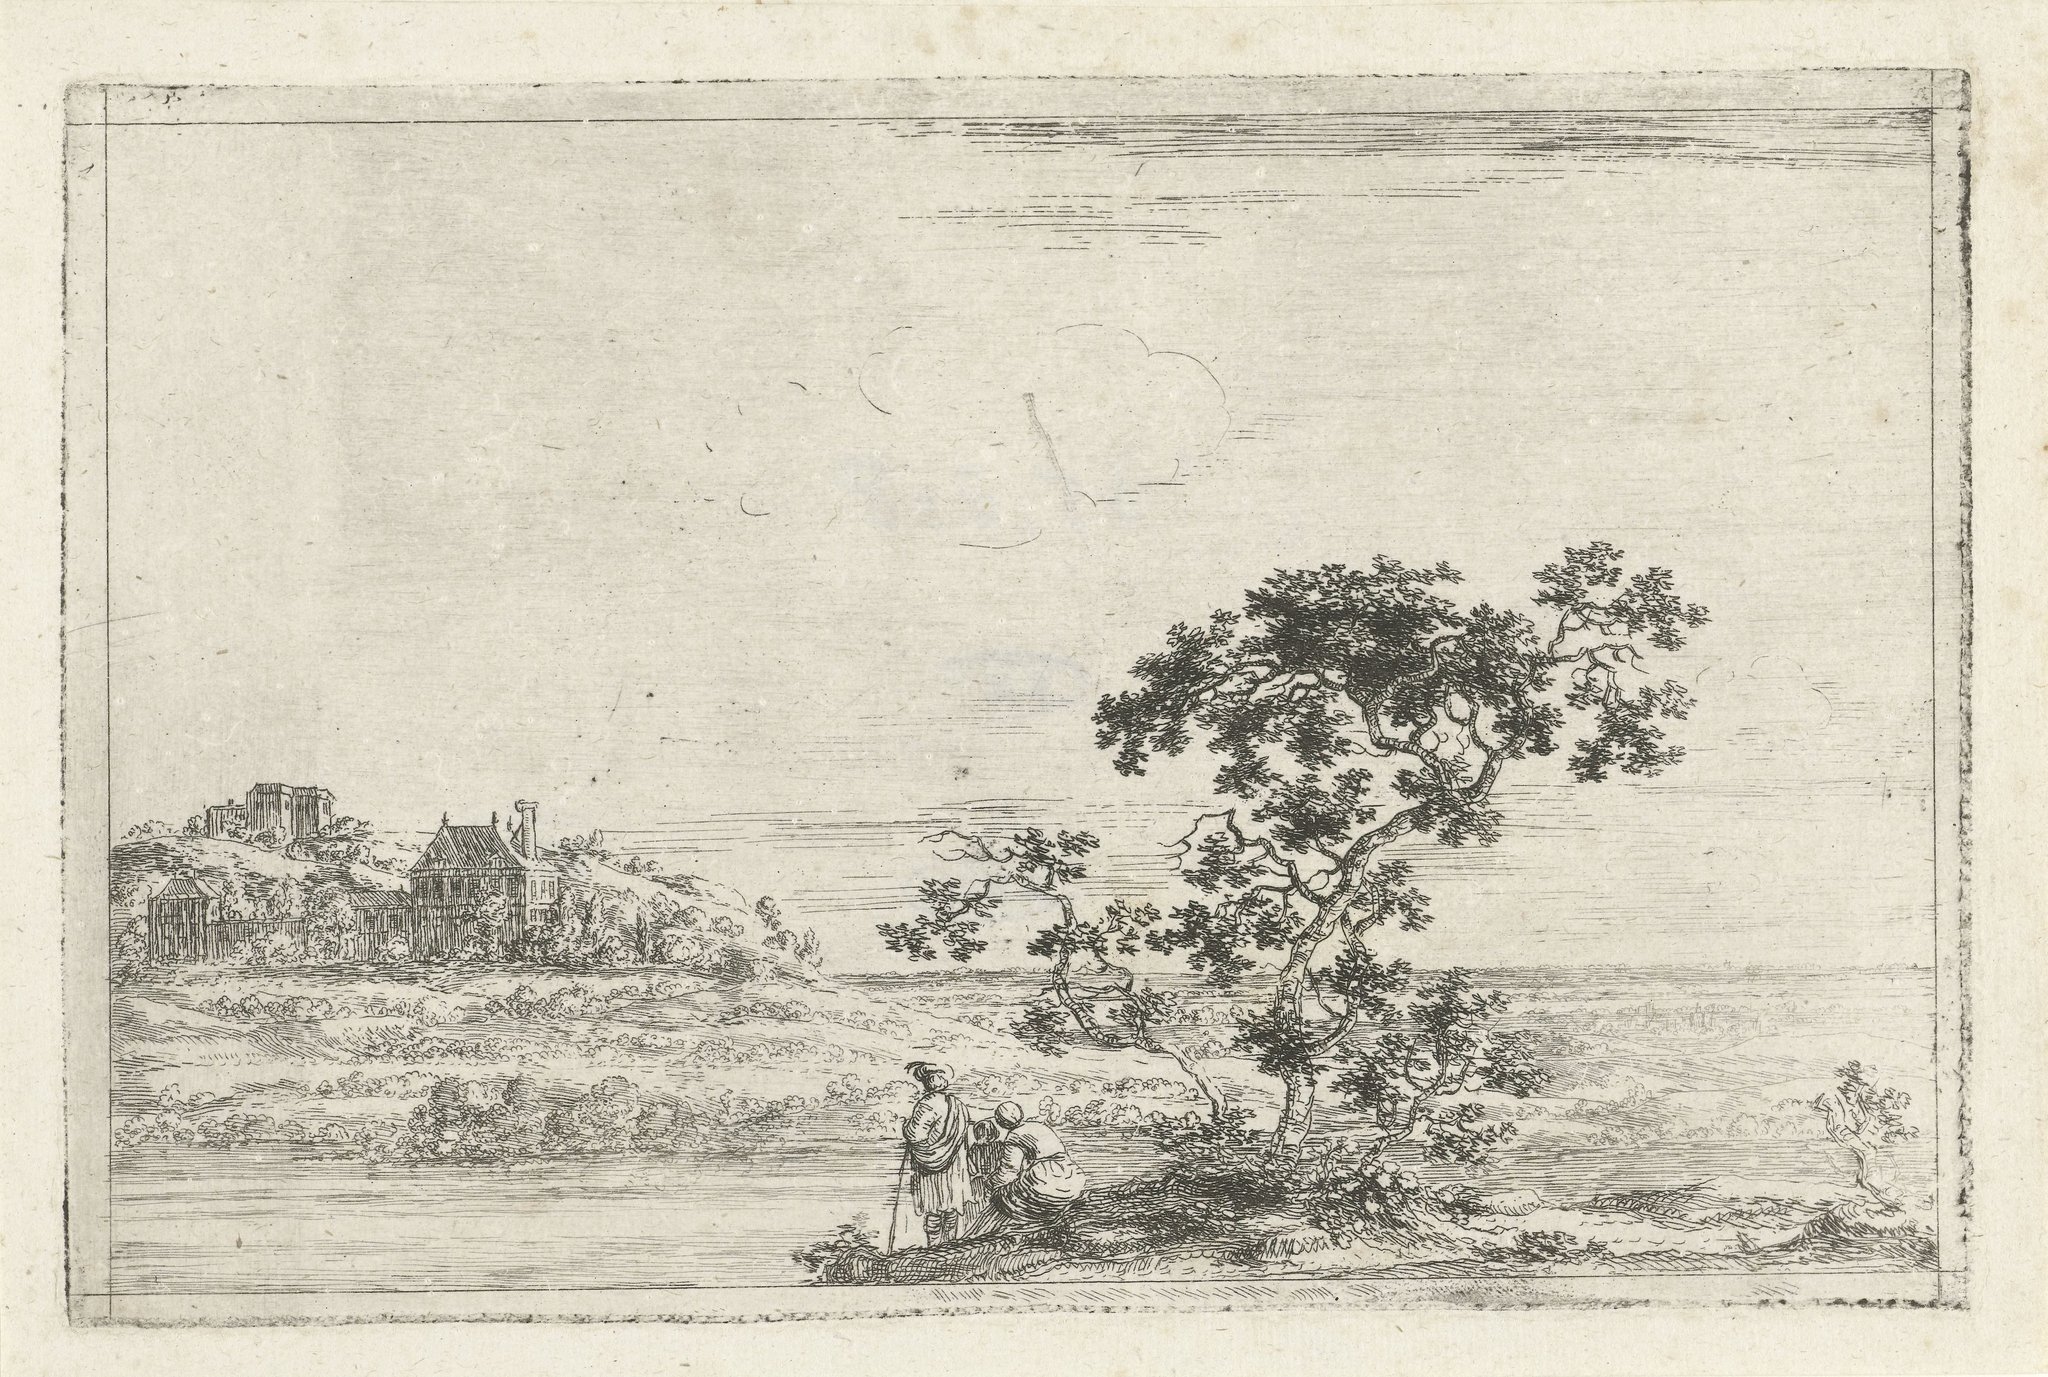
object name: print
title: Landschap met figuren bij een boom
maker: joris van der haagen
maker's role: draughtsman, painter, print maker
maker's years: 1615-1669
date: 1630-1669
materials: paper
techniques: etching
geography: northern netherlands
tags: rural housing, e.g. country-house, villa, cottage, farm or solitary house in landscape (+ city(-scape) with figures, staffage)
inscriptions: collector's mark: Lugt 2166, collector's mark: Lugt 2228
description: Landschap met op de voorgrond figuren bij een boom en in de achtergrond huizen op een heuvel.